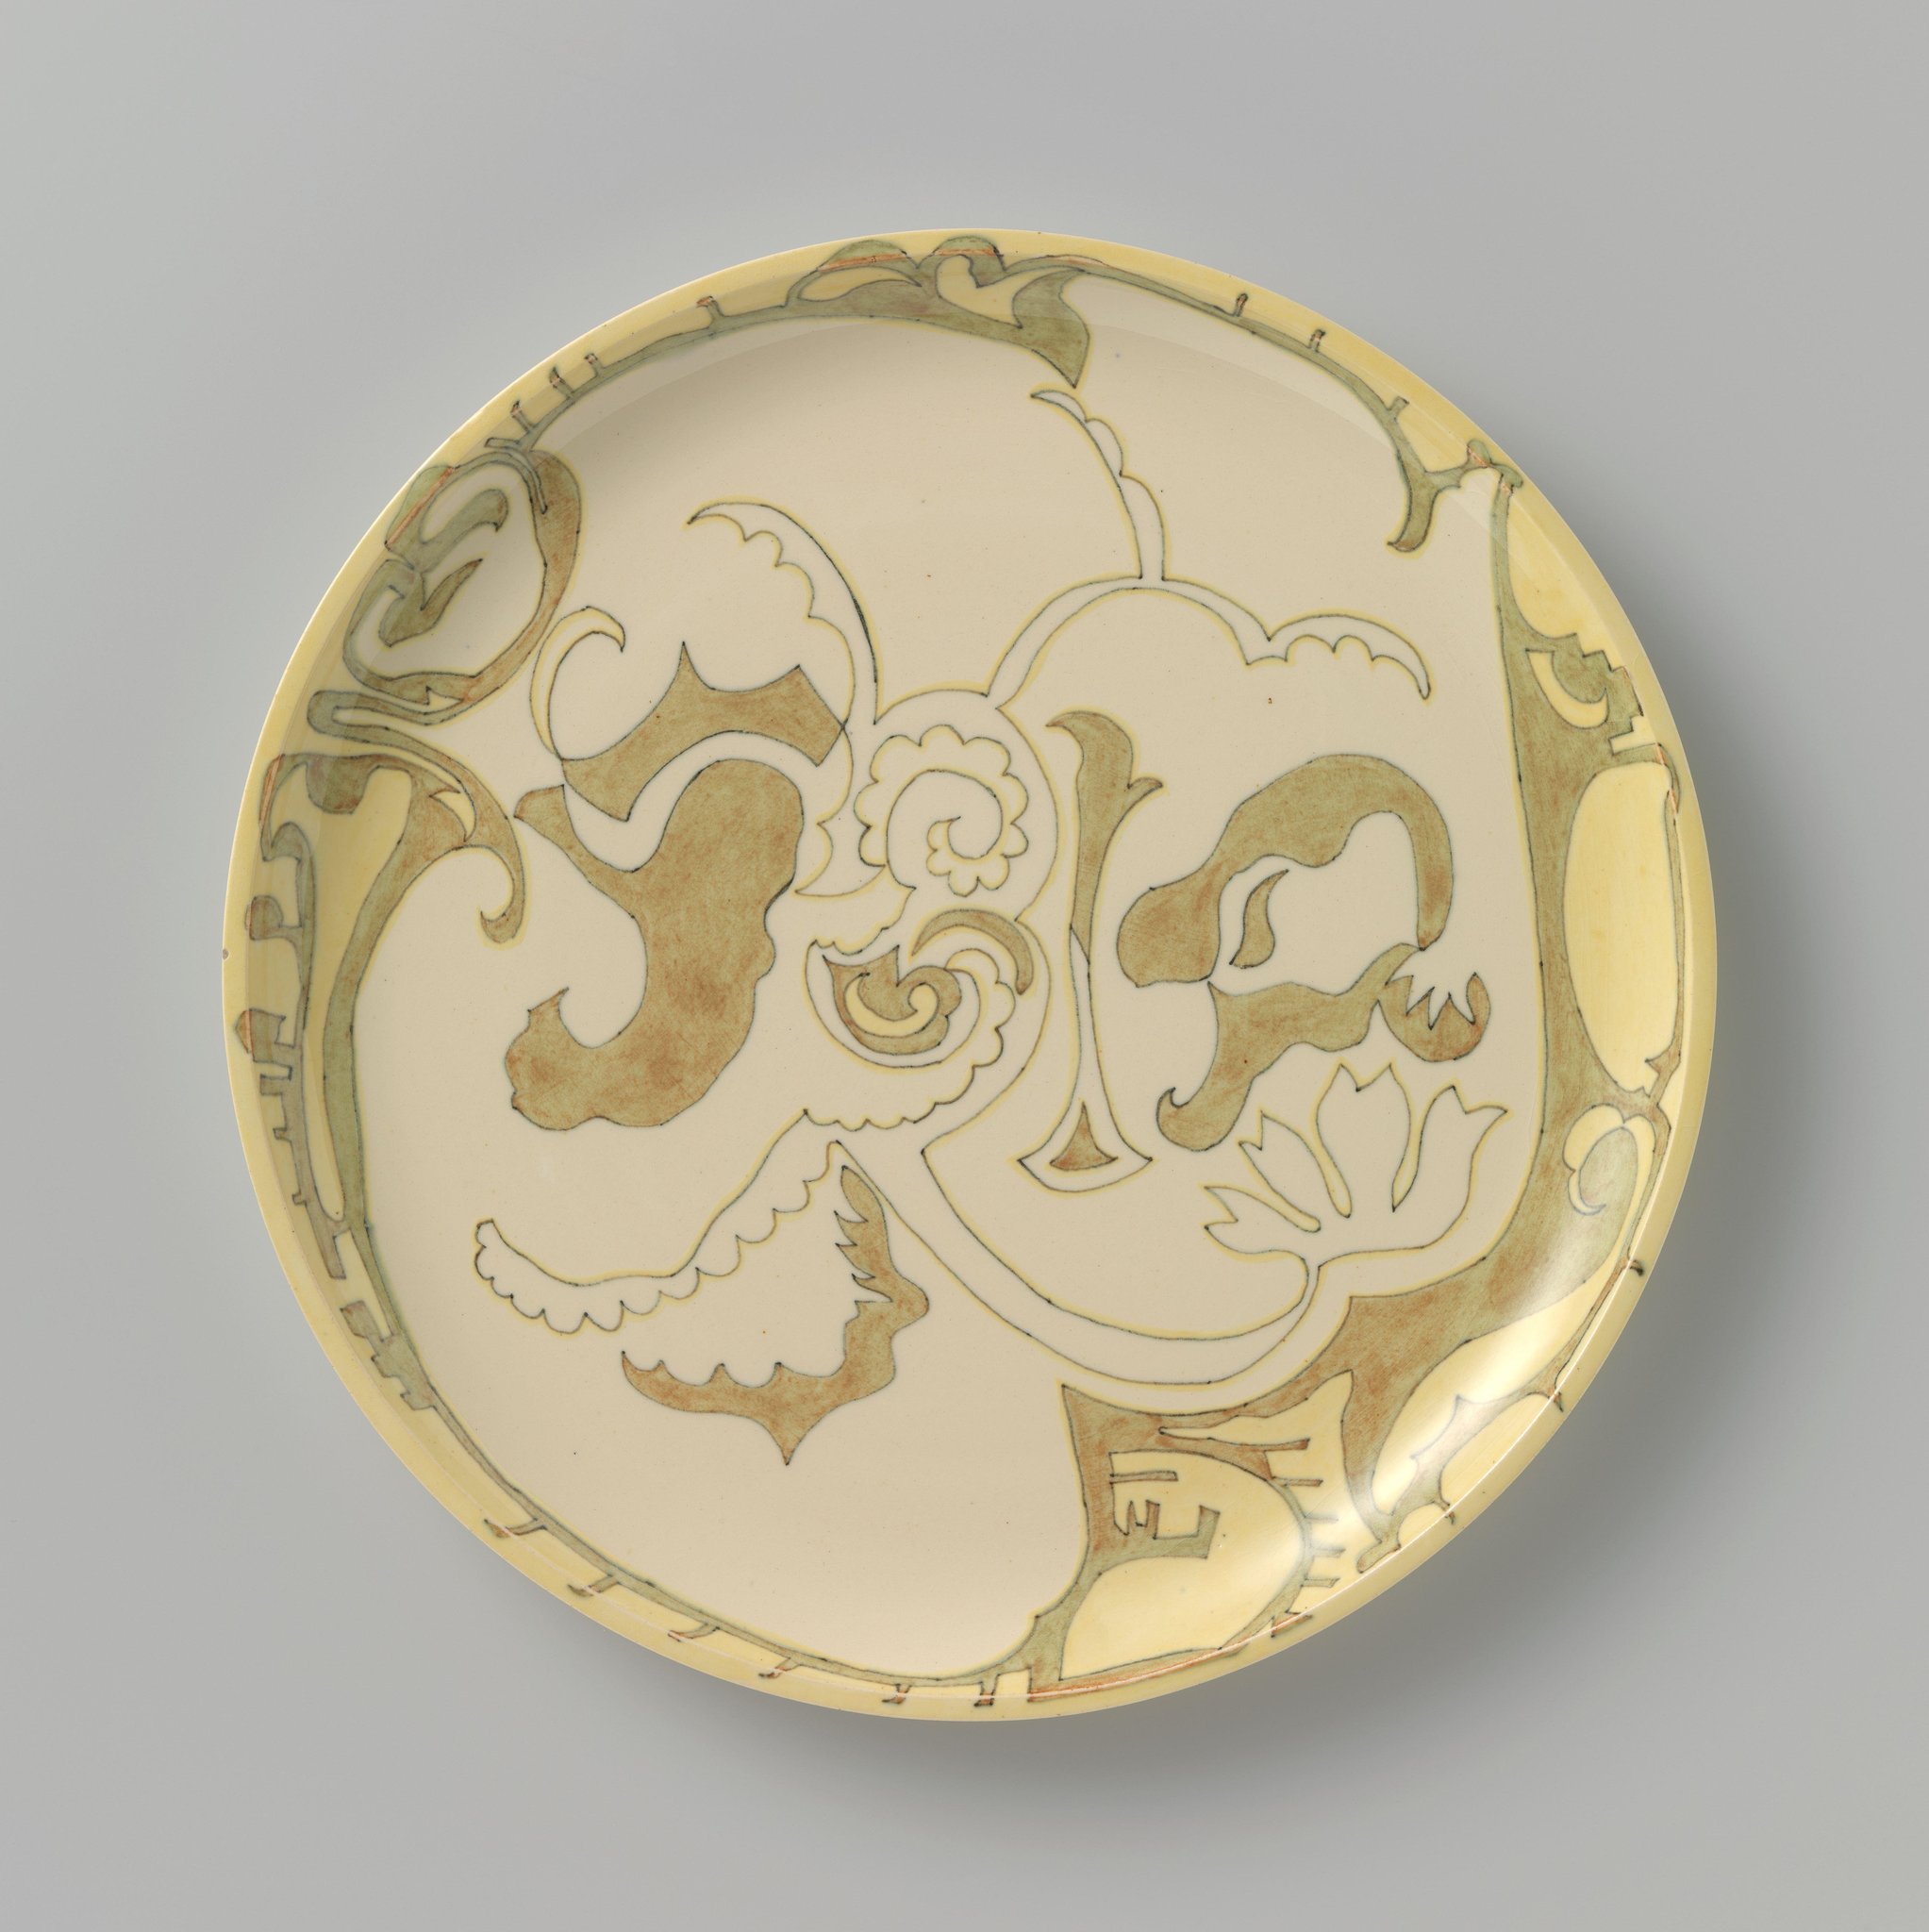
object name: wandbord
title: Wandbord met gestileerd floraal motief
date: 1887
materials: earthenware, glaze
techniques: painted, vitrification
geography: the hague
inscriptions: : ‘C’, : ‘I 3. takje’, : ‘WvG den haag’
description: Wandbord met blank fond, waarover in groenbruin en geel een gestileerd floraal motief is aangebracht. Het motief is zwart omtrokken.